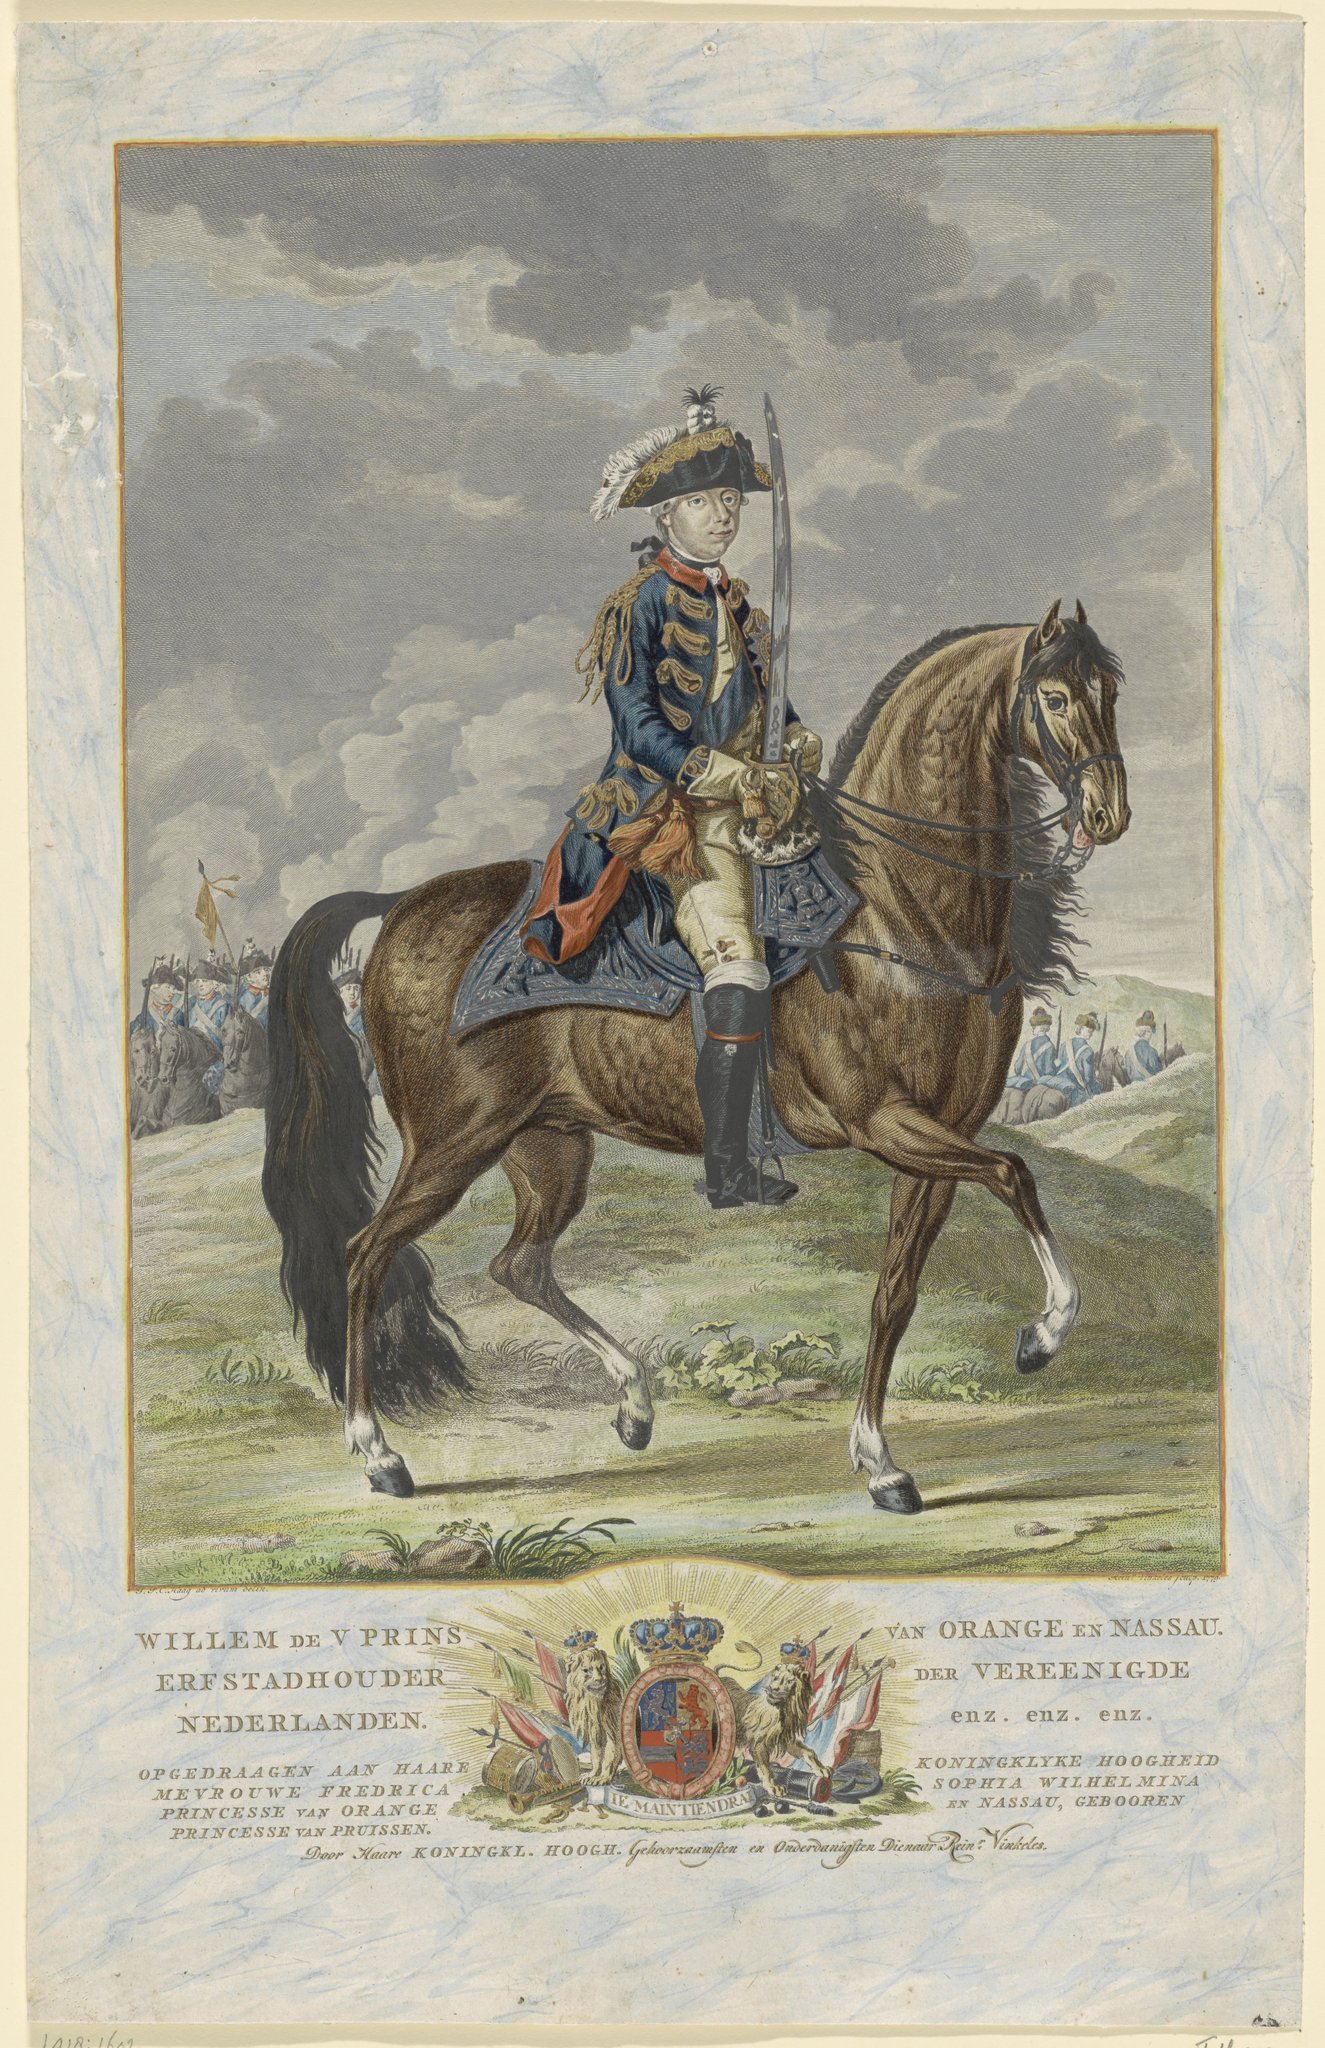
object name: print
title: Ruiterportret van Willem V, prins van Oranje-Nassau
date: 1779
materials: paper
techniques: engraving, etching, hand coloring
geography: amsterdam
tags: the hague, william v (prince of orange), knighthood order (garter) - insignia of a knighthood order, e.g.: badge, chain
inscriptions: collector's mark: Lugt 2228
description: Ruiterportret van Willem V. Midden onder zijn wapen met een kroon en twee leeuwen, gedecoreerd met de Kousenband en het devies van de Orde van de Kousenband. Daaronder op een banderol zijn geslachtsspreuk. In de ondermarge zijn naam en titels. Losse verklarende tekst in boekdruk.